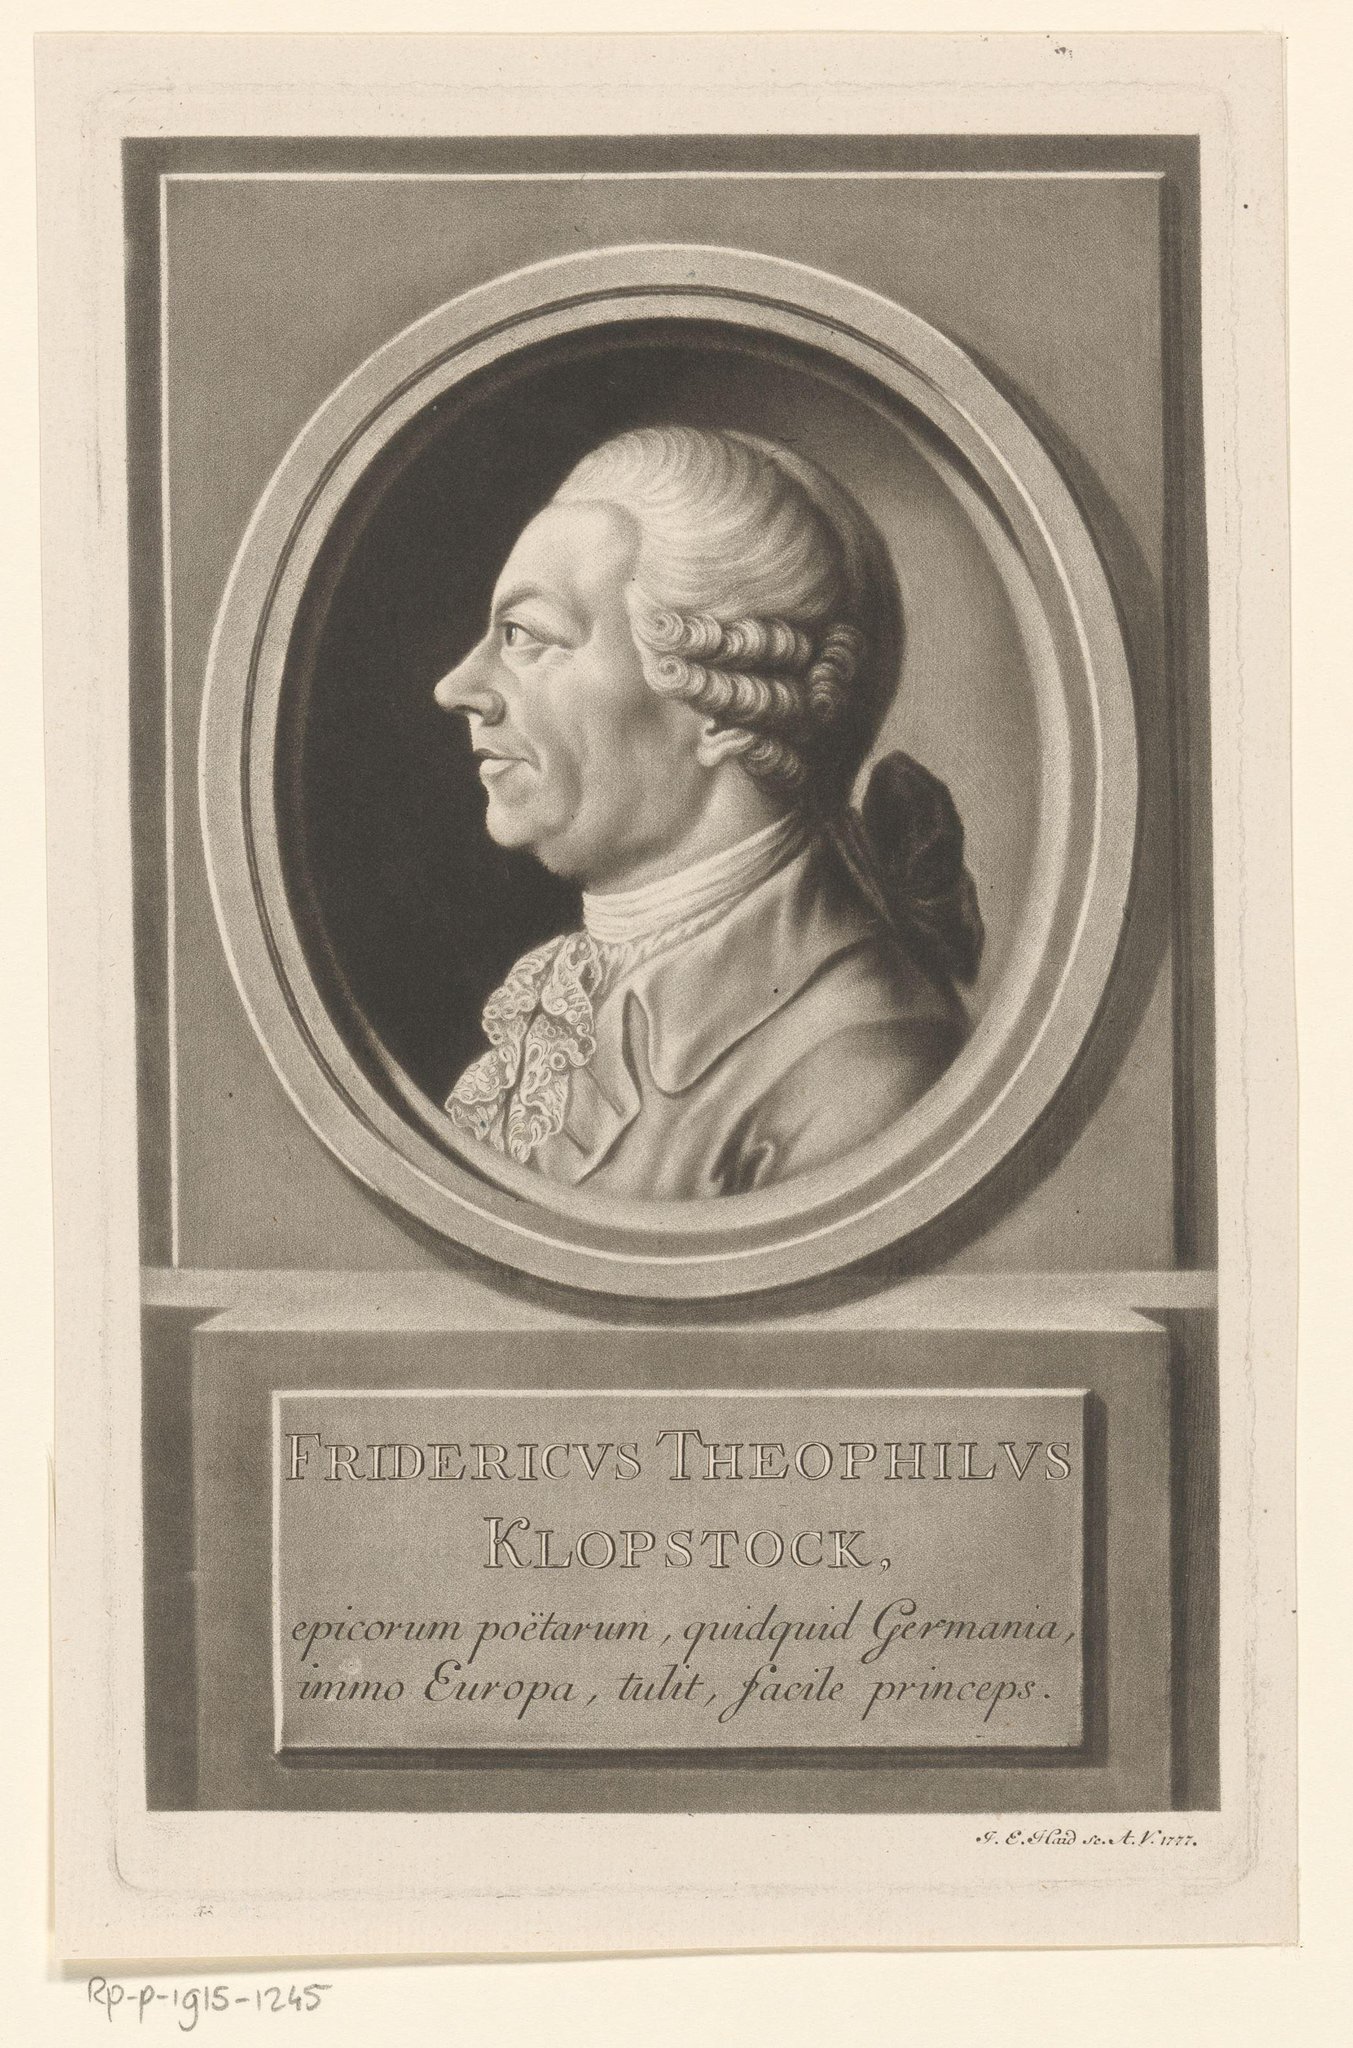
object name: print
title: Portret van Friedrich Gottlieb Klopstock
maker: johann elias haid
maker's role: print maker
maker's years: 1739-1809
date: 1777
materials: paper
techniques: mezzotint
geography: augsburg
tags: historical persons, writer, poet, author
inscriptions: collector's mark: Lugt 2228